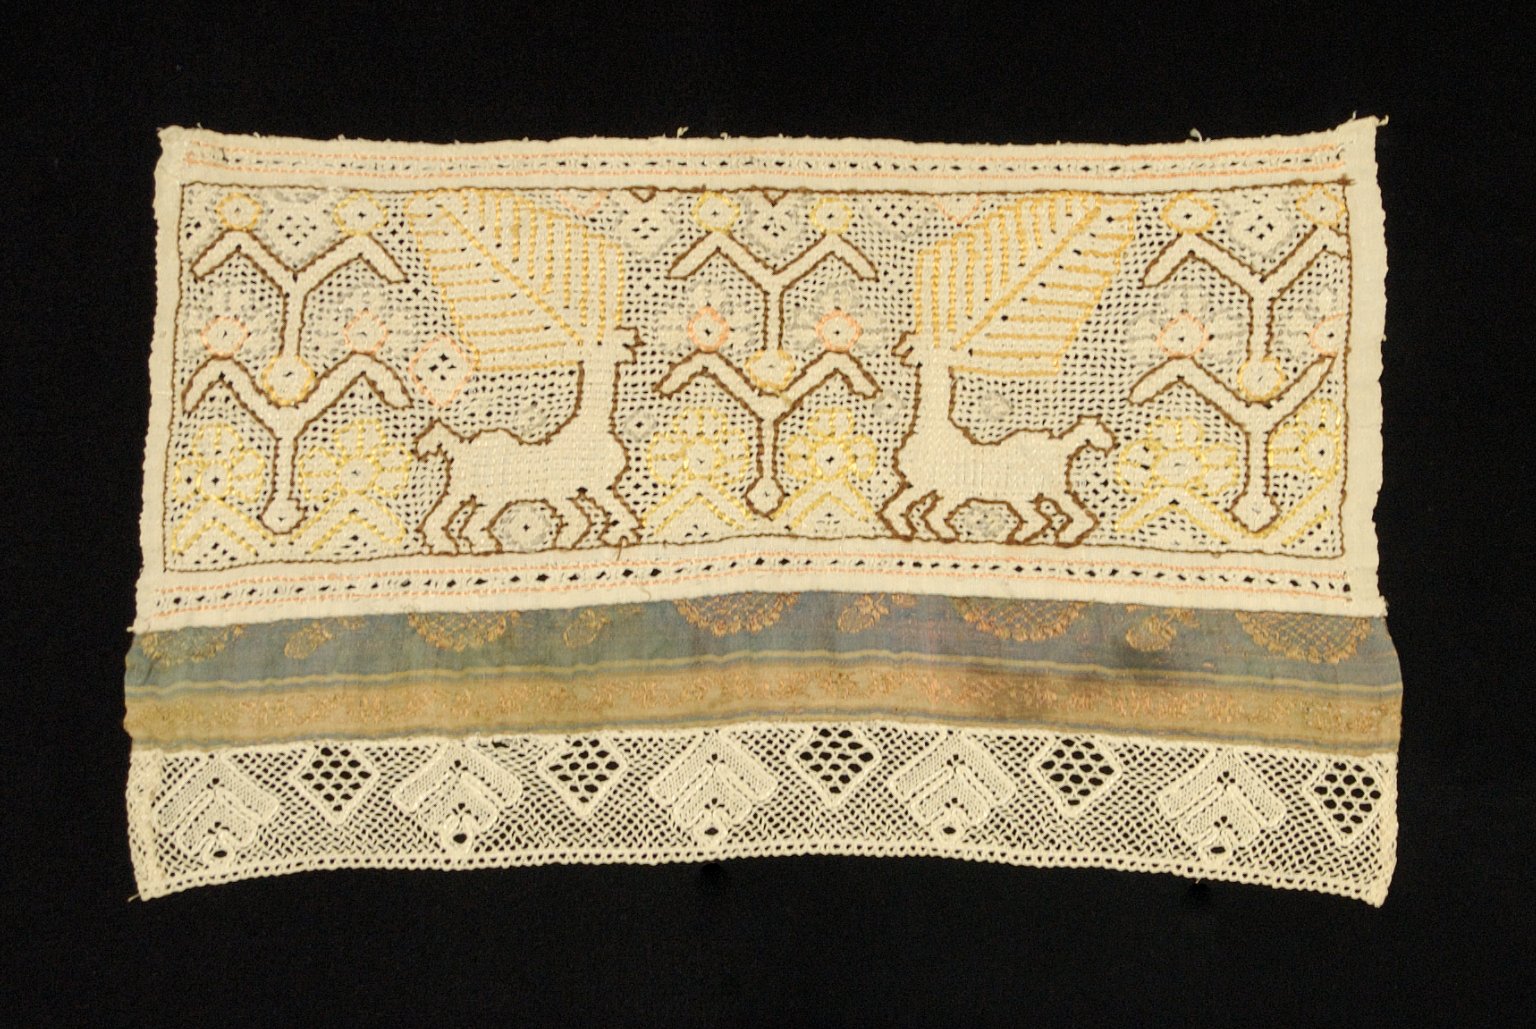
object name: border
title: Towel border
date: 1800-1850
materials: linen, silk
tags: animals